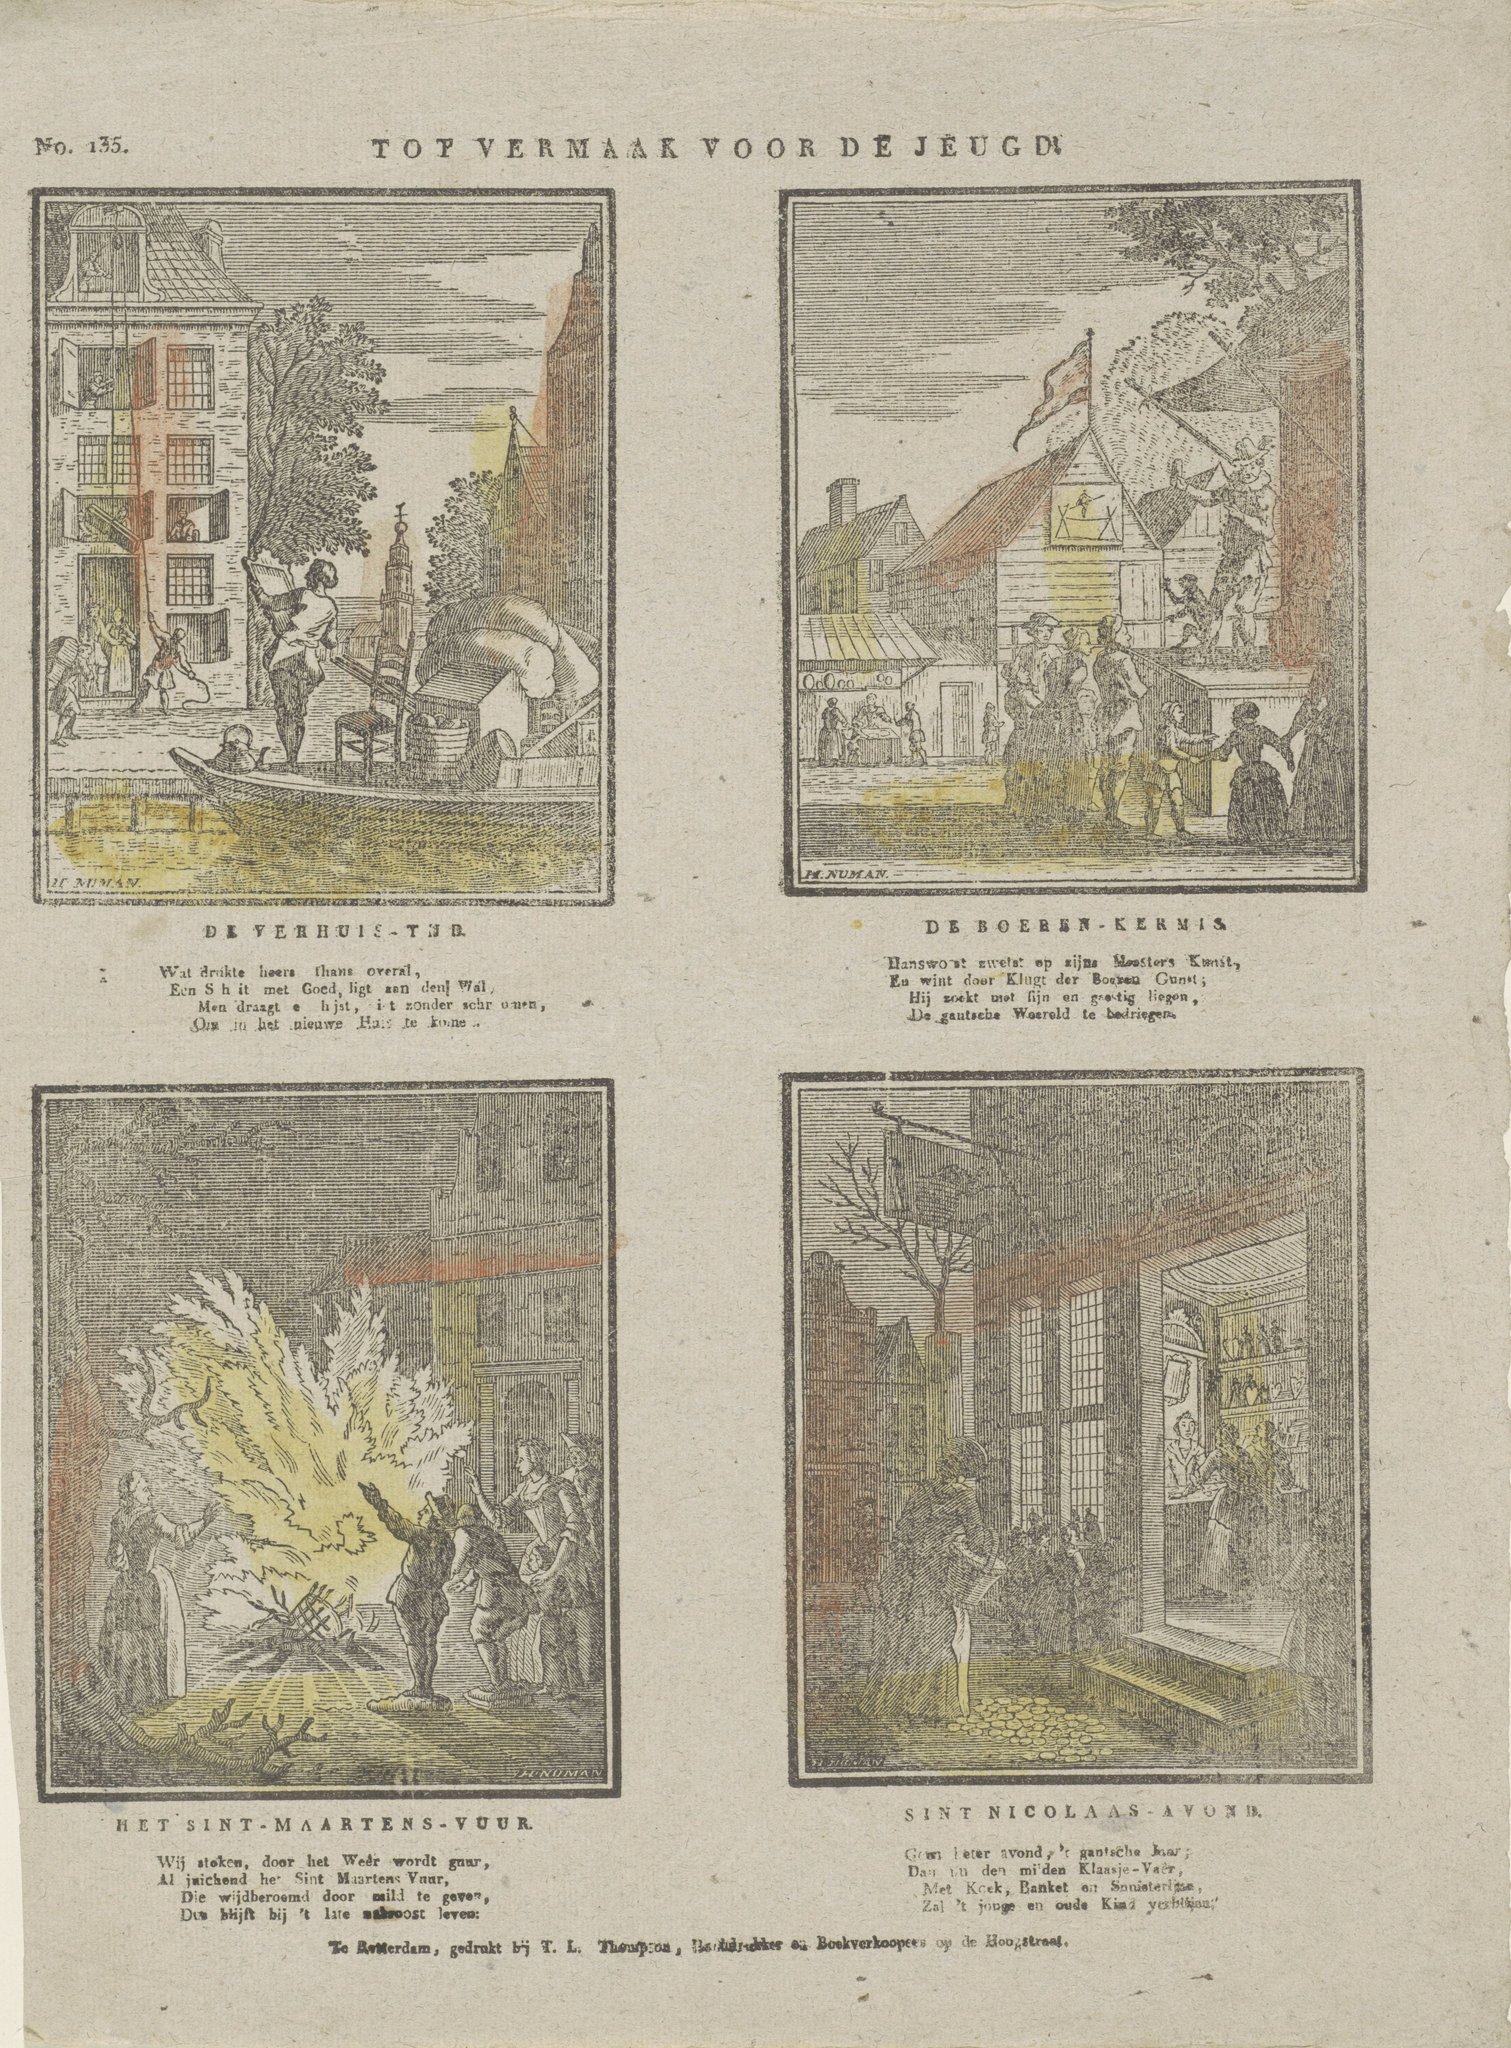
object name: print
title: Tot vermaak voor de jeugd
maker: t.l. thompson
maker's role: bookseller, publisher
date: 1825-1838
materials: paper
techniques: colour, letterpress printing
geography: rotterdam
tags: moving (house), st. martin's day (november 11), festivities on st. nicholas (eve) (december 5), pleasure fair and circus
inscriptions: collector's mark: Lugt 2760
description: Blad met 4 voorstellingen van de verhuistijd, de boerenkermis, het Sint Maartensvuur en Sinterklaasavond. Onder elke afbeelding een titel en een vierregelig vers. Genummerd linksboven: No. 135.